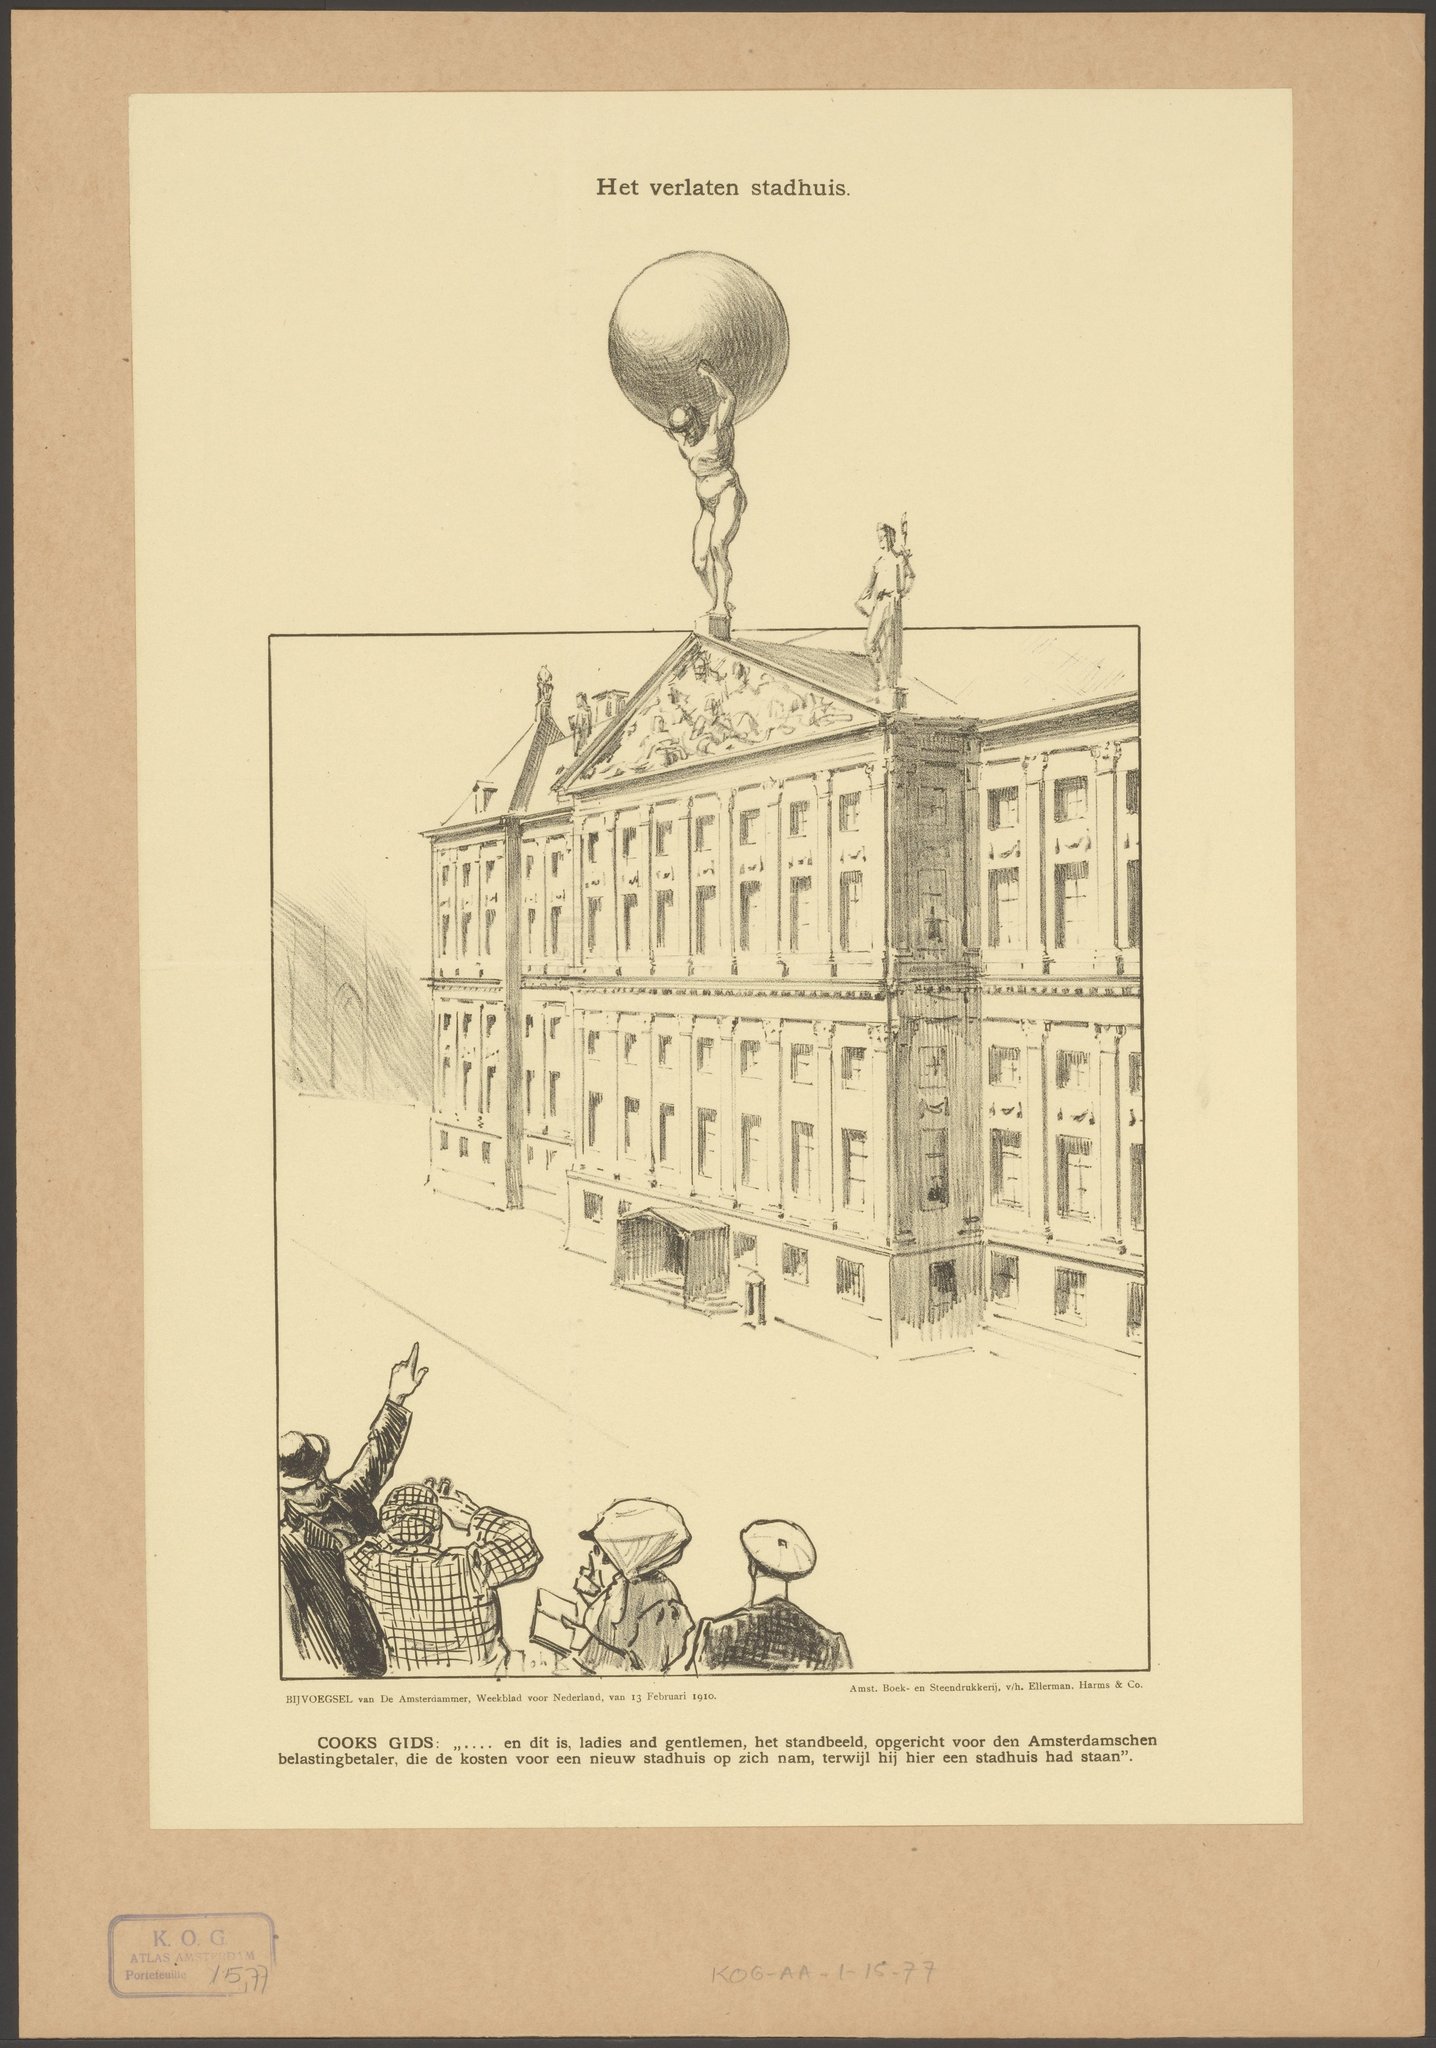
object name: cartoon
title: Spotprent over de Paleis-Raadhuiskwestie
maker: Anonymous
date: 1910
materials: paper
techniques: letterpress printing, lithograph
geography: amsterdam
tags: city-view in general; 'veduta', palace, townhall, royal palace of amsterdam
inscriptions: collector's mark: ‘15,77’ Lugt 1641b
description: Onderwerpsrubriek binnen de Atlas Amsterdam: Nieuwe Stadhuis op de Dam, van buiten, Kleine steentjes kwestie, Paleis - Raadhuiskwestie.